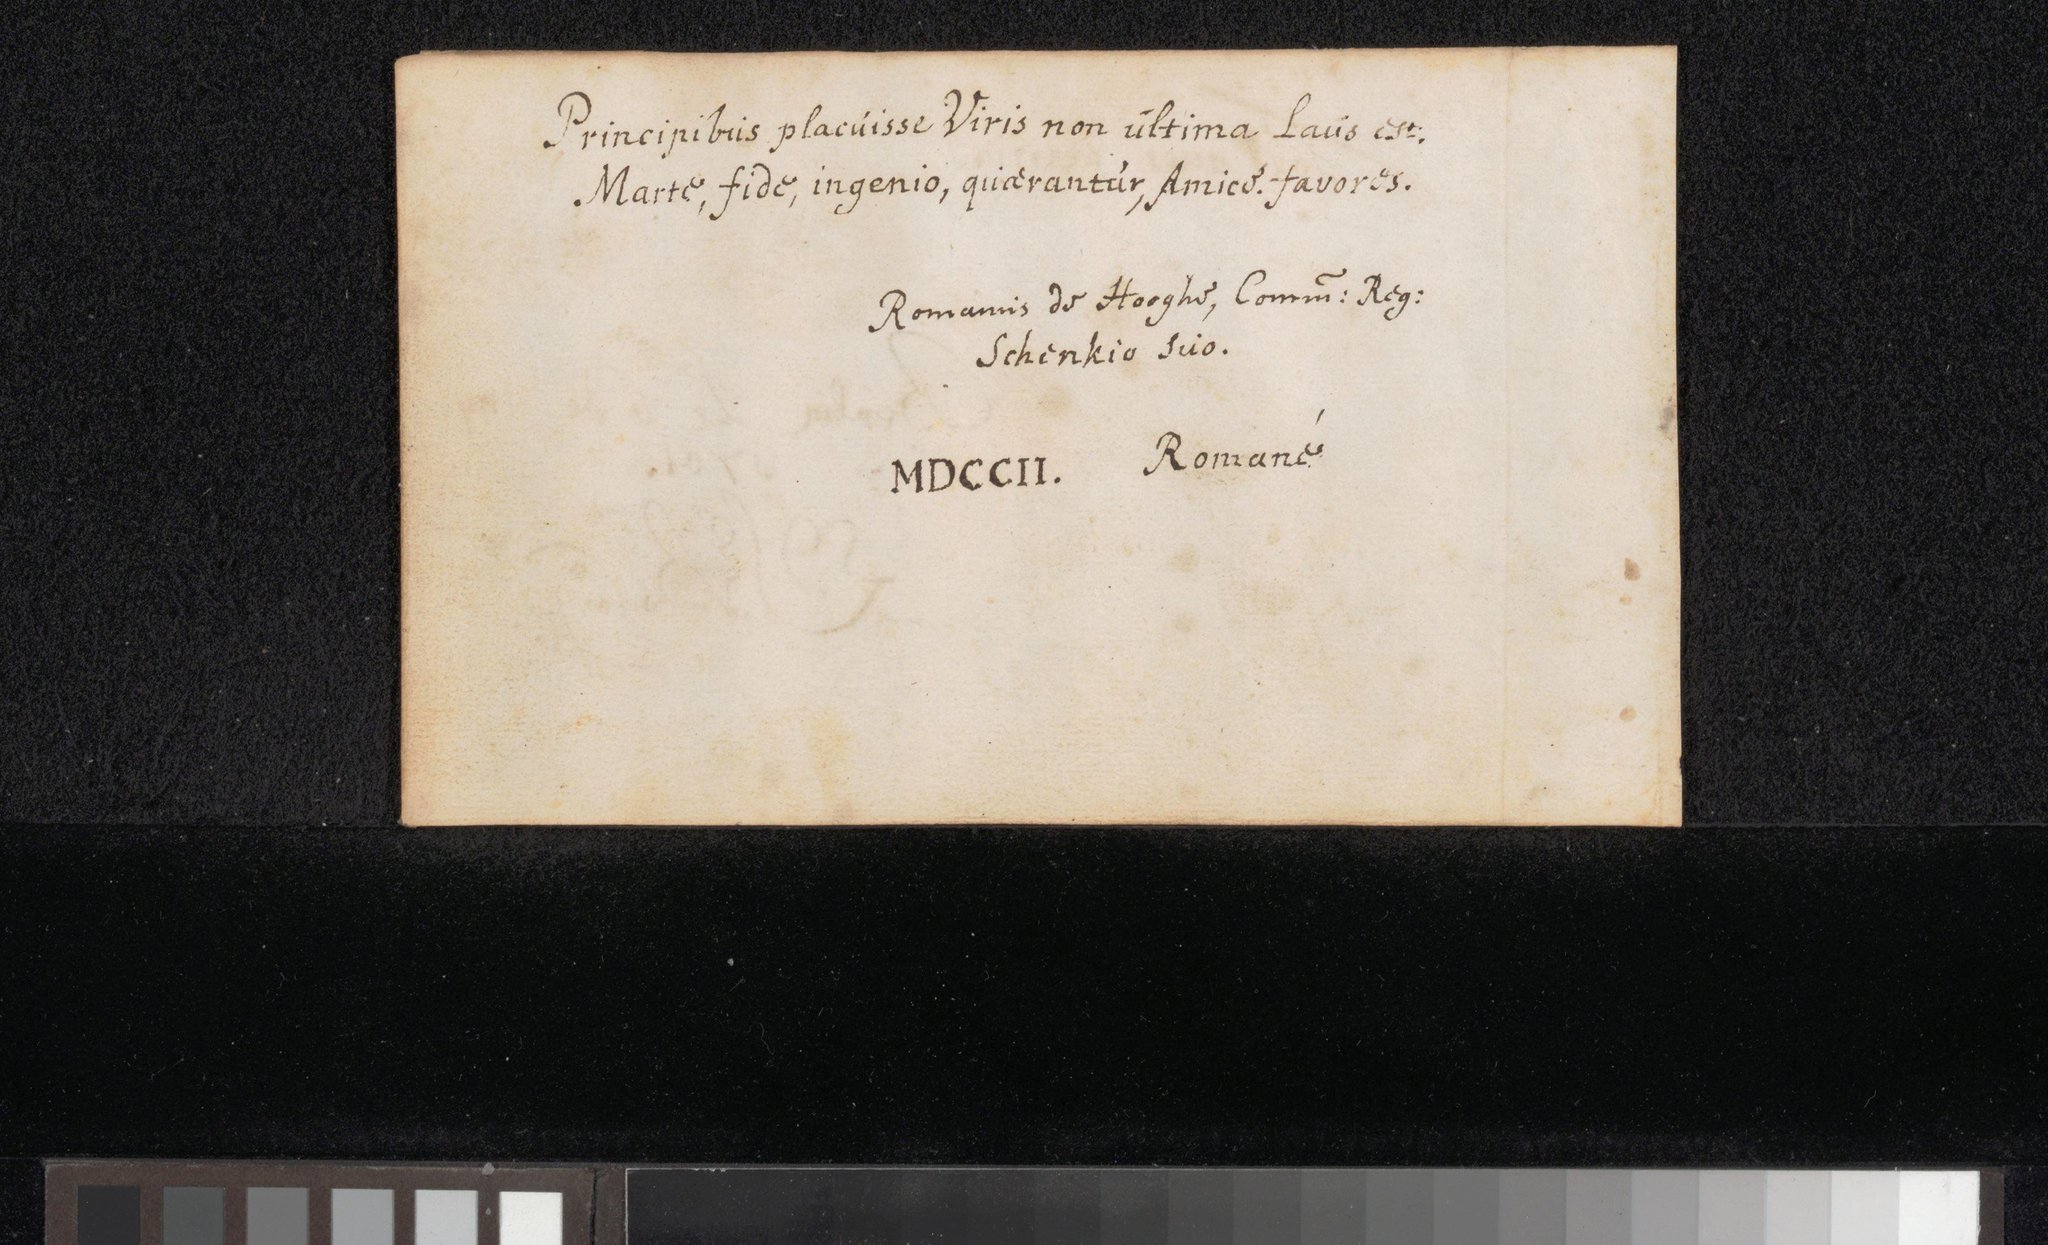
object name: letter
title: Brief aan anoniem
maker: romeyn de hooghe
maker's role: draughtsman, goldsmith, painter, print maker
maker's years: 1645-1708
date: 1702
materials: ink, paper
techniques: pen, writing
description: Vermoedelijk gericht aan een familielid.